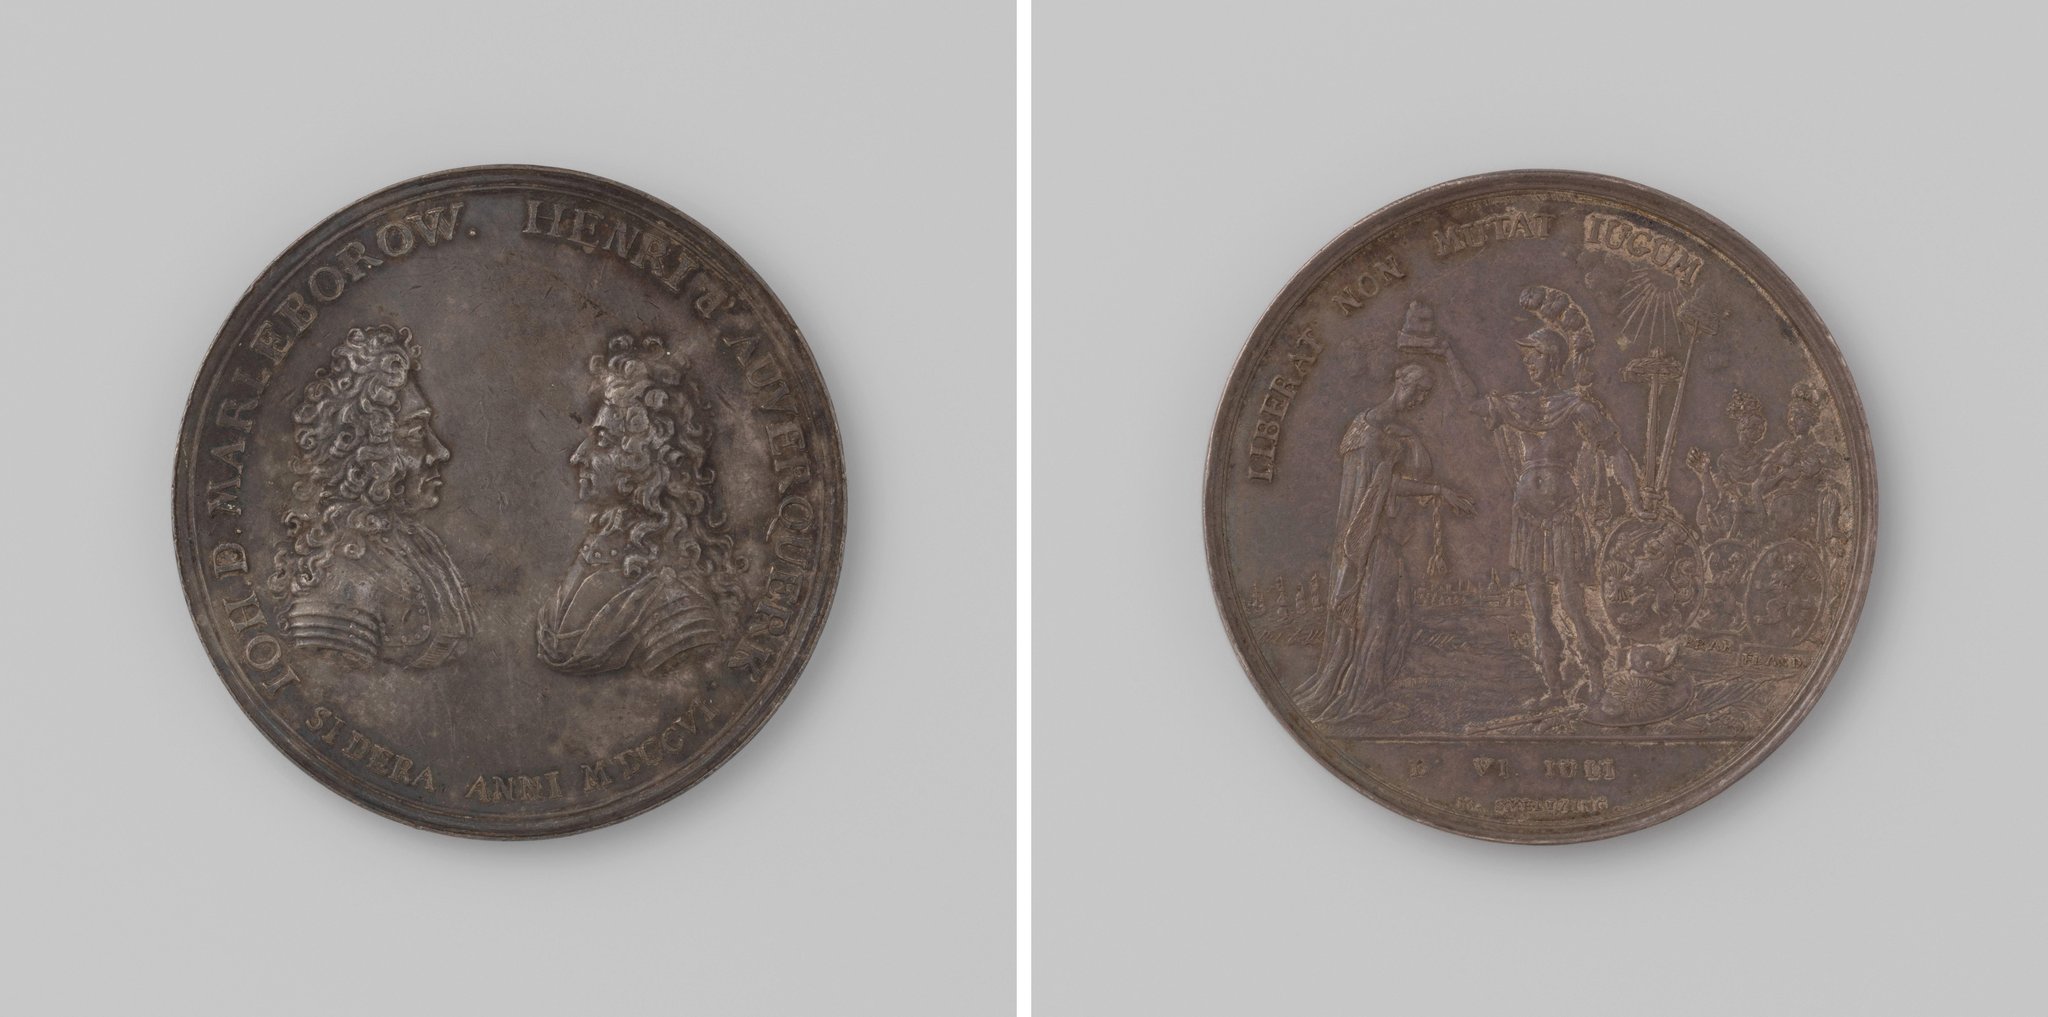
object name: history medal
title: Verovering van Oostende, ter ere van de hertog van Marlborough en de Hendrik van Nassau-Ouwerkerk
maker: martin schmeltzing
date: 1706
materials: silver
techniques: striking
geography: amsterdam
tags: john churchill (1e hertog van marlborough), the hague